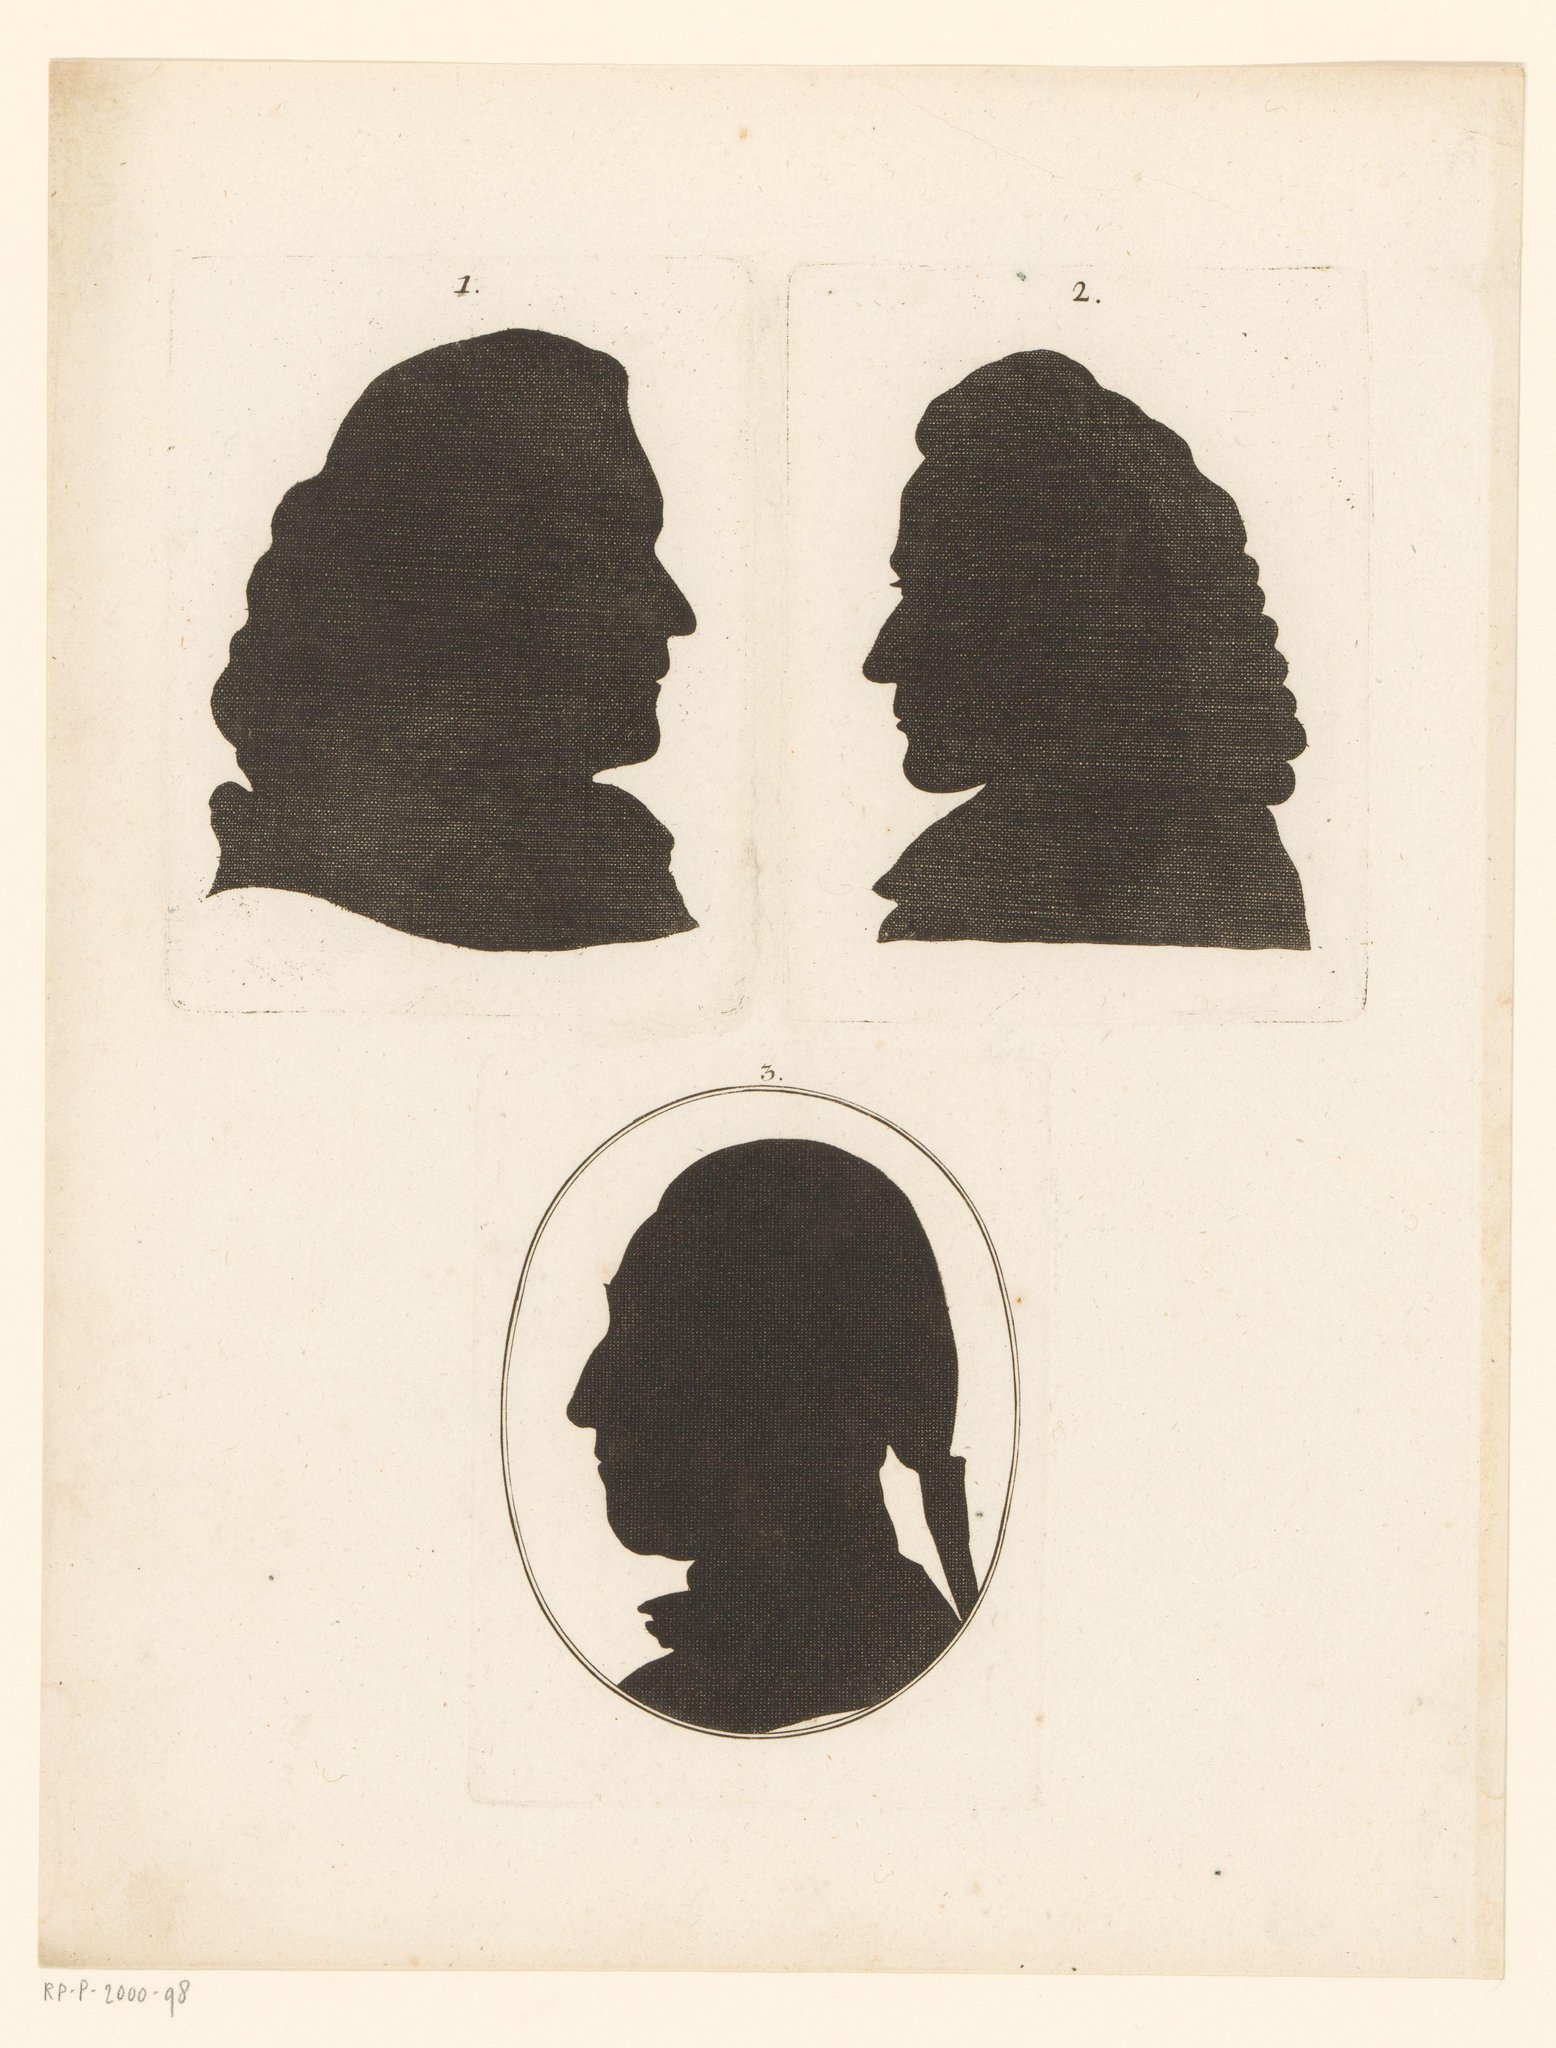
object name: print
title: Drie silhouetportretten van onbekende mannen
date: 1700-1799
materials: paper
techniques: engraving, etching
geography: germany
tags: silhouette-apparatus, 'physionotrace'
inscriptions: collector's mark: Lugt 2760, collector's mark: Lugt 2228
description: Mogelijk drie keer dezelfde plaat gebruikt, vanwege hetzelfde formaat.